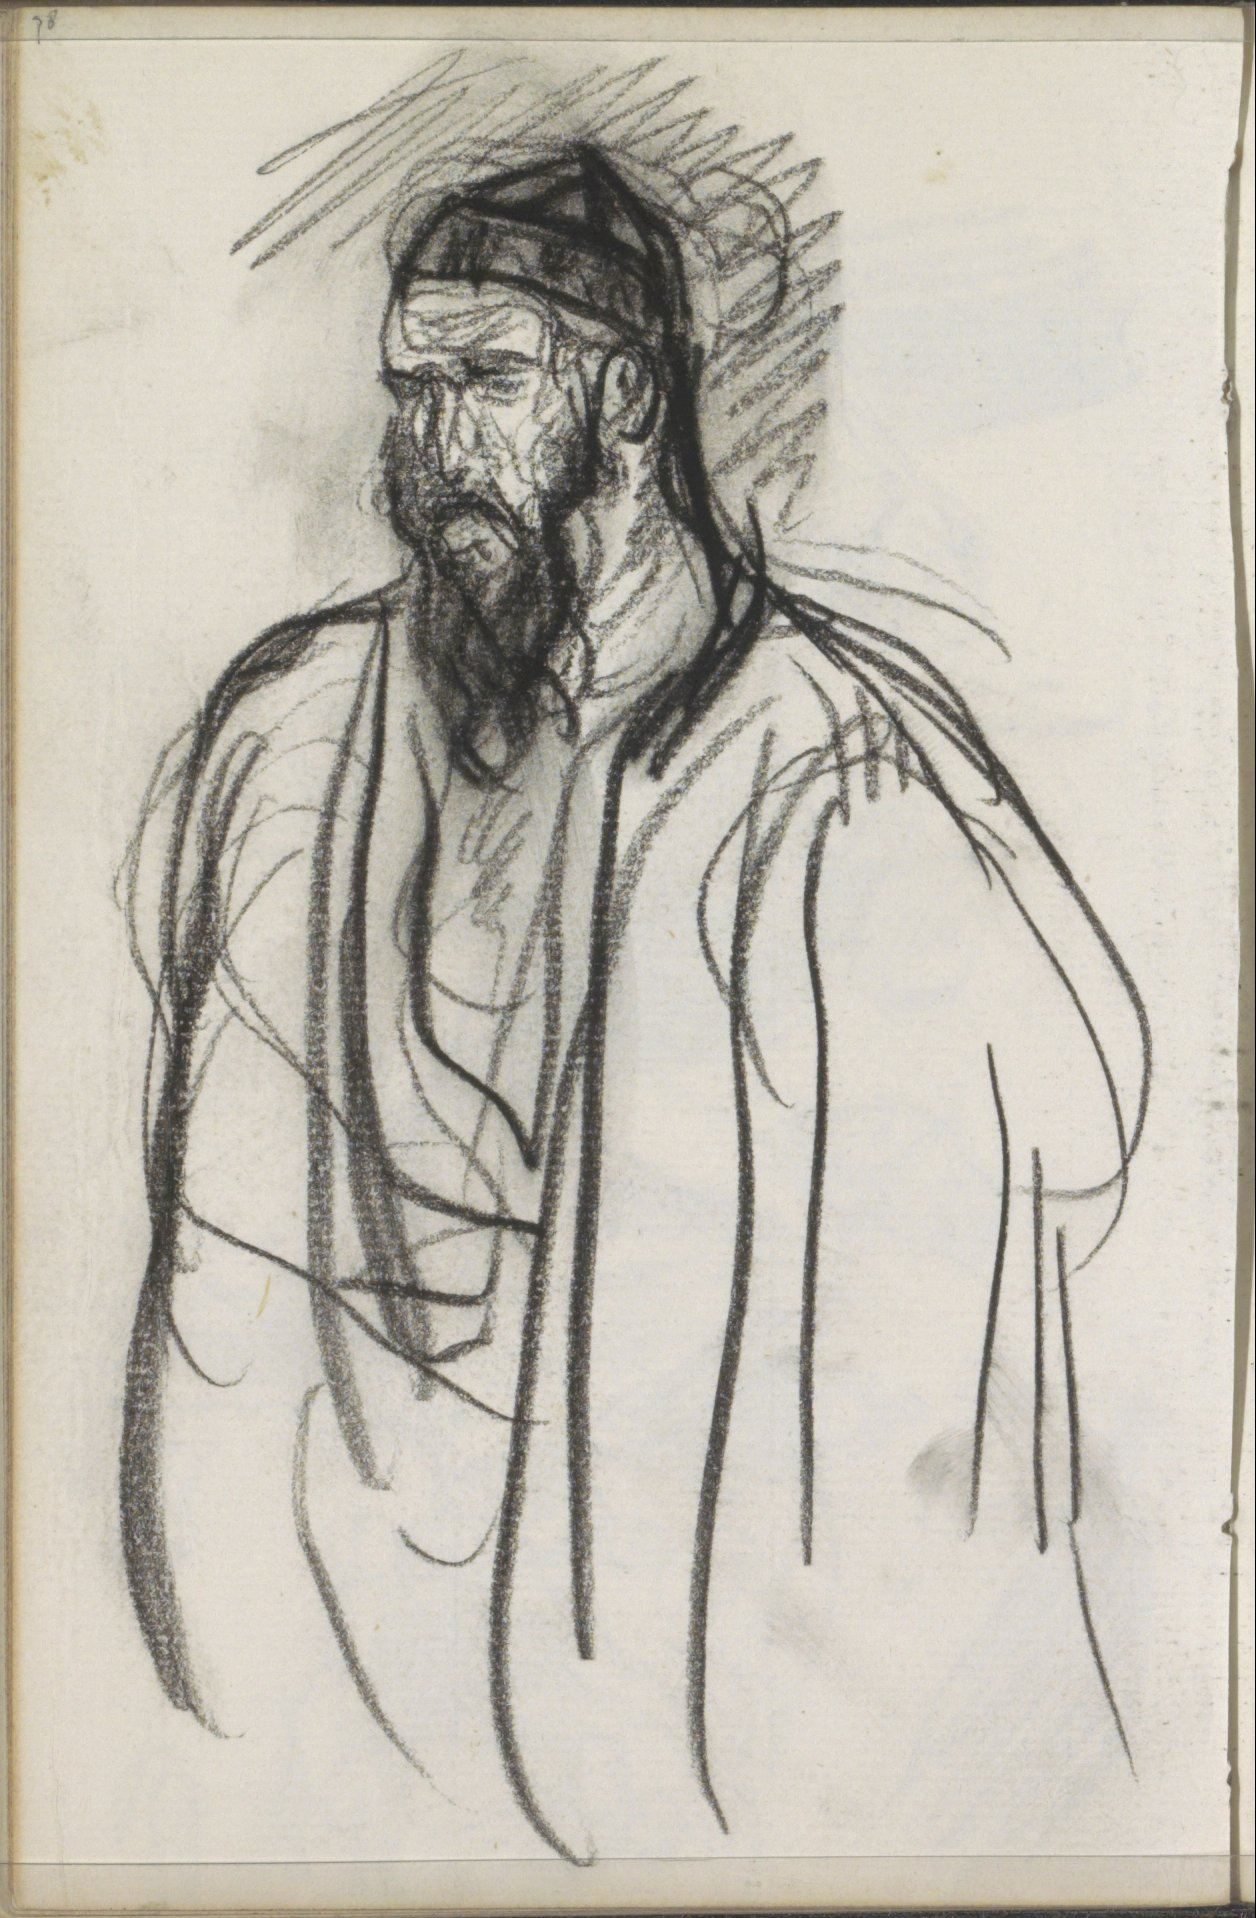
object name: sketchbook leaf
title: Man in oosterse kleding, ten halven lijve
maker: marius bauer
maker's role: draughtsman, print maker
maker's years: 1867-1932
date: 1899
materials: chalk, paper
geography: turkey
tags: asiatic races and peoples, adult man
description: Pagina 78 uit een schetsboek met 42 bladen.